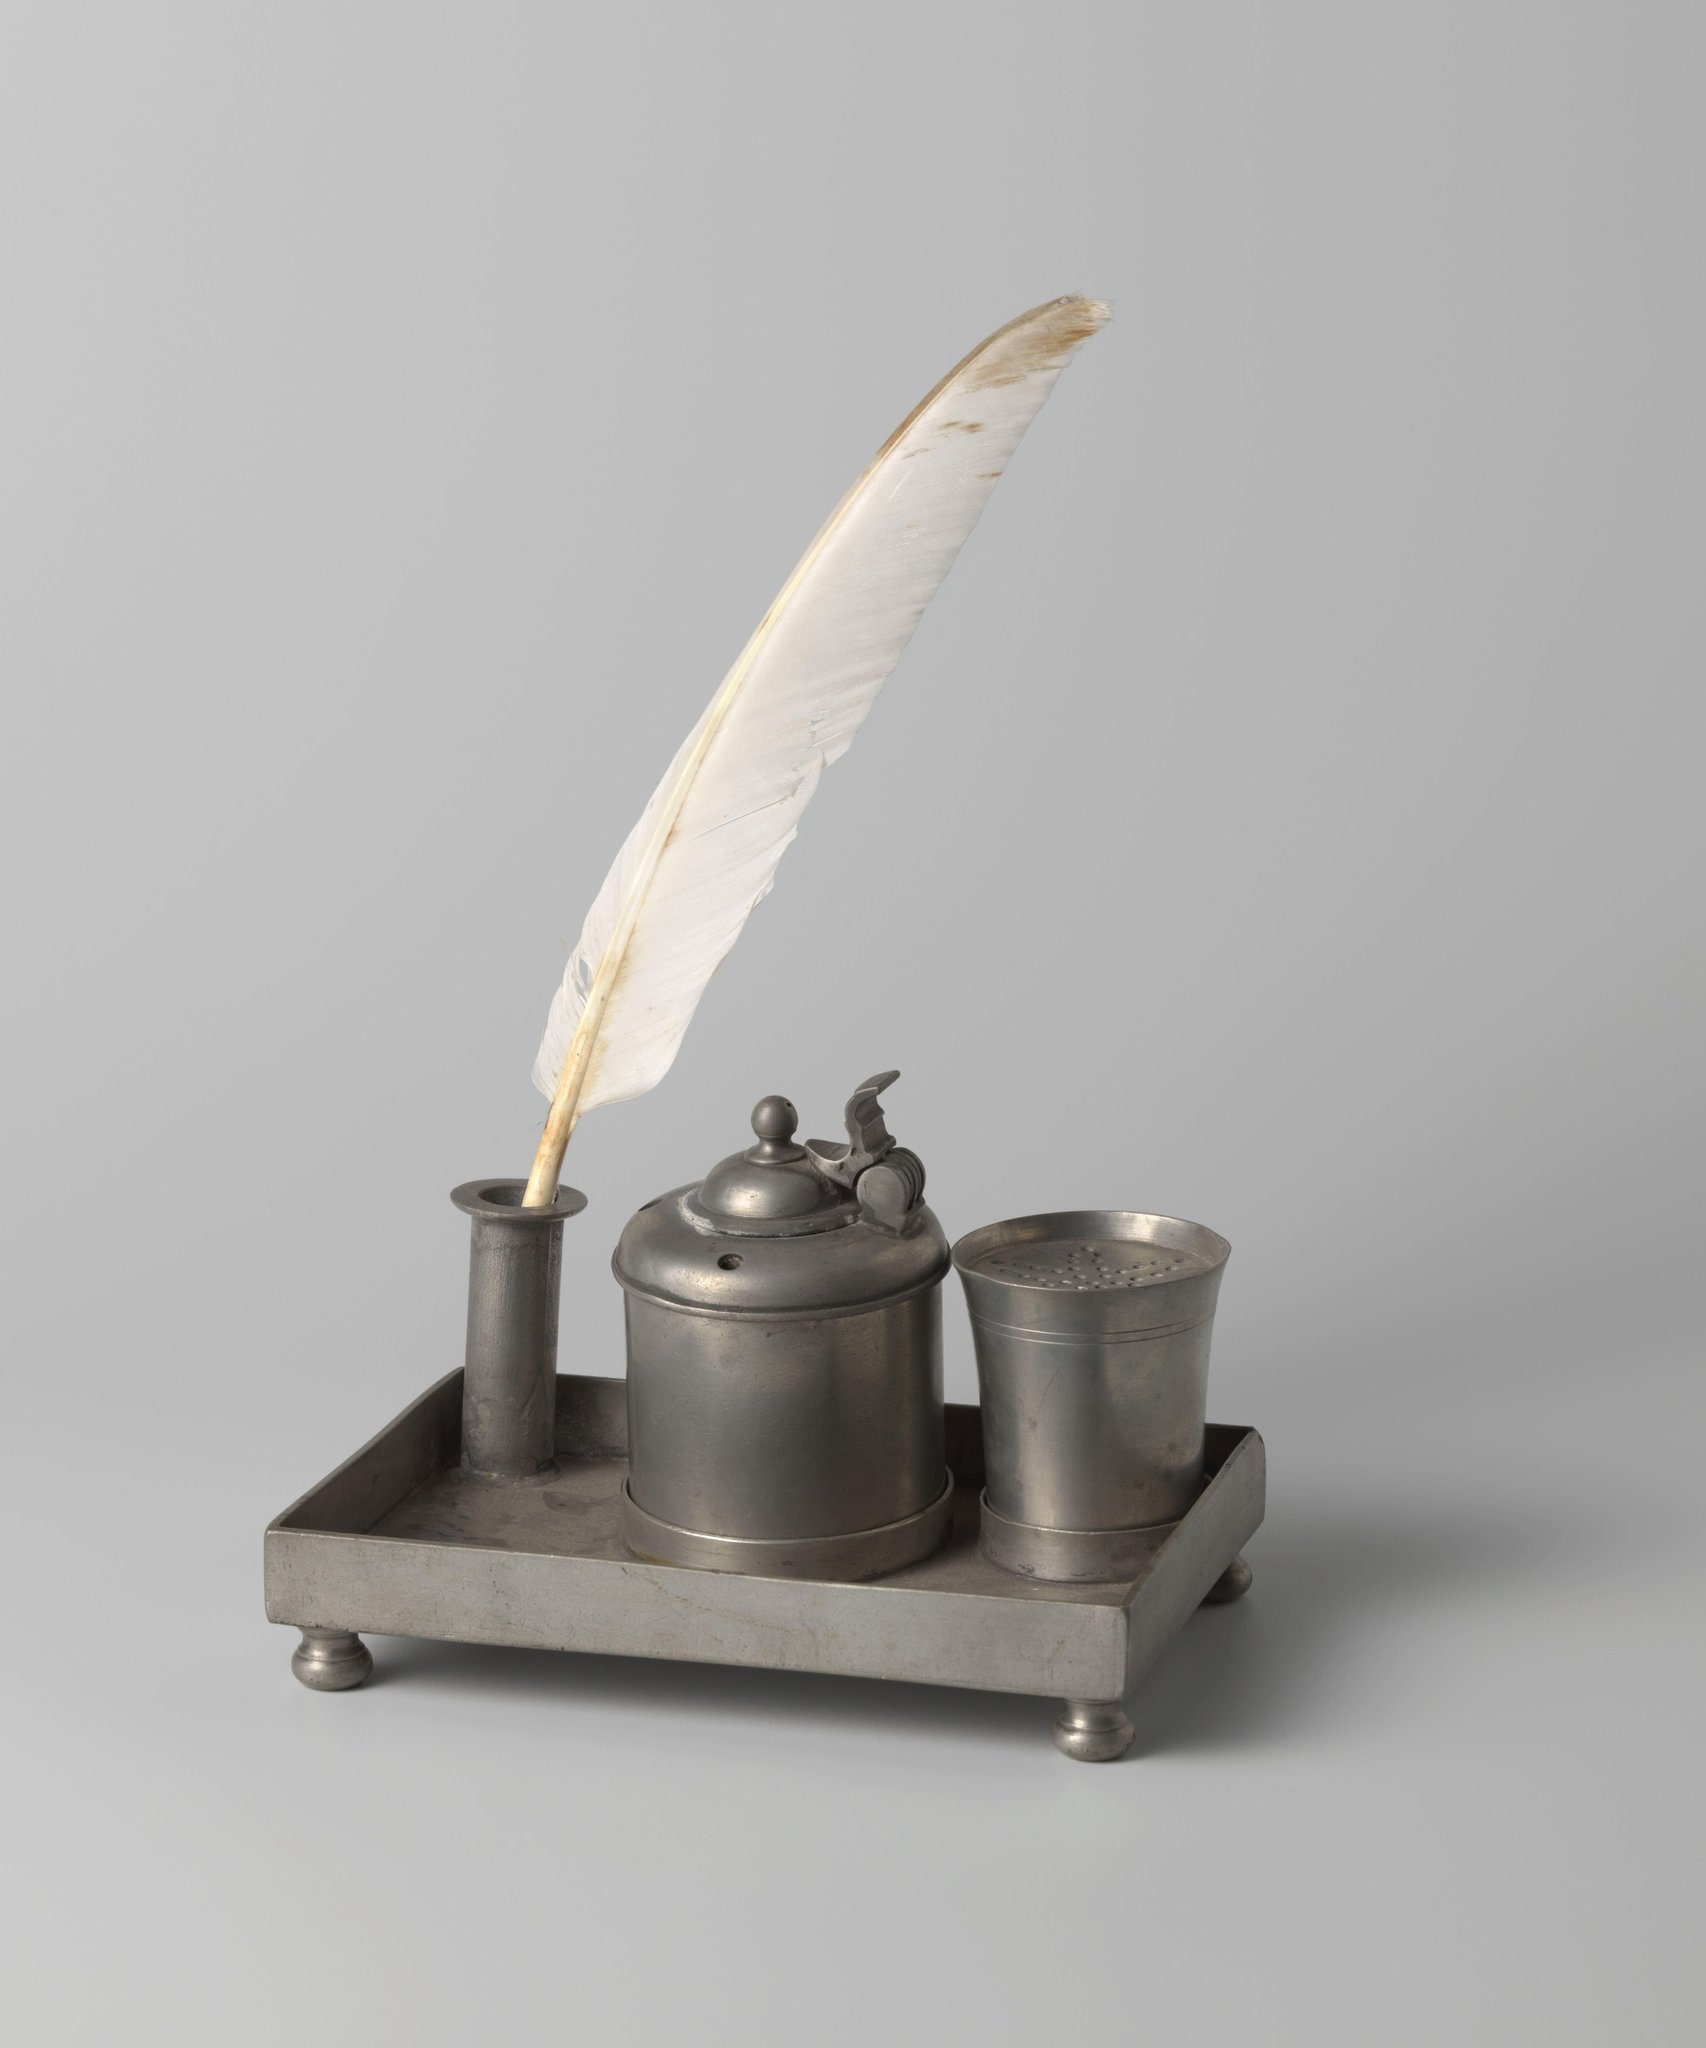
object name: pen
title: Schrijfveer van inktstel van tin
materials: feather, tin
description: Schrijfveer behorende bij een inktstel van tin. De lange witte veer heeft bij de penaanzet resten van inkt.